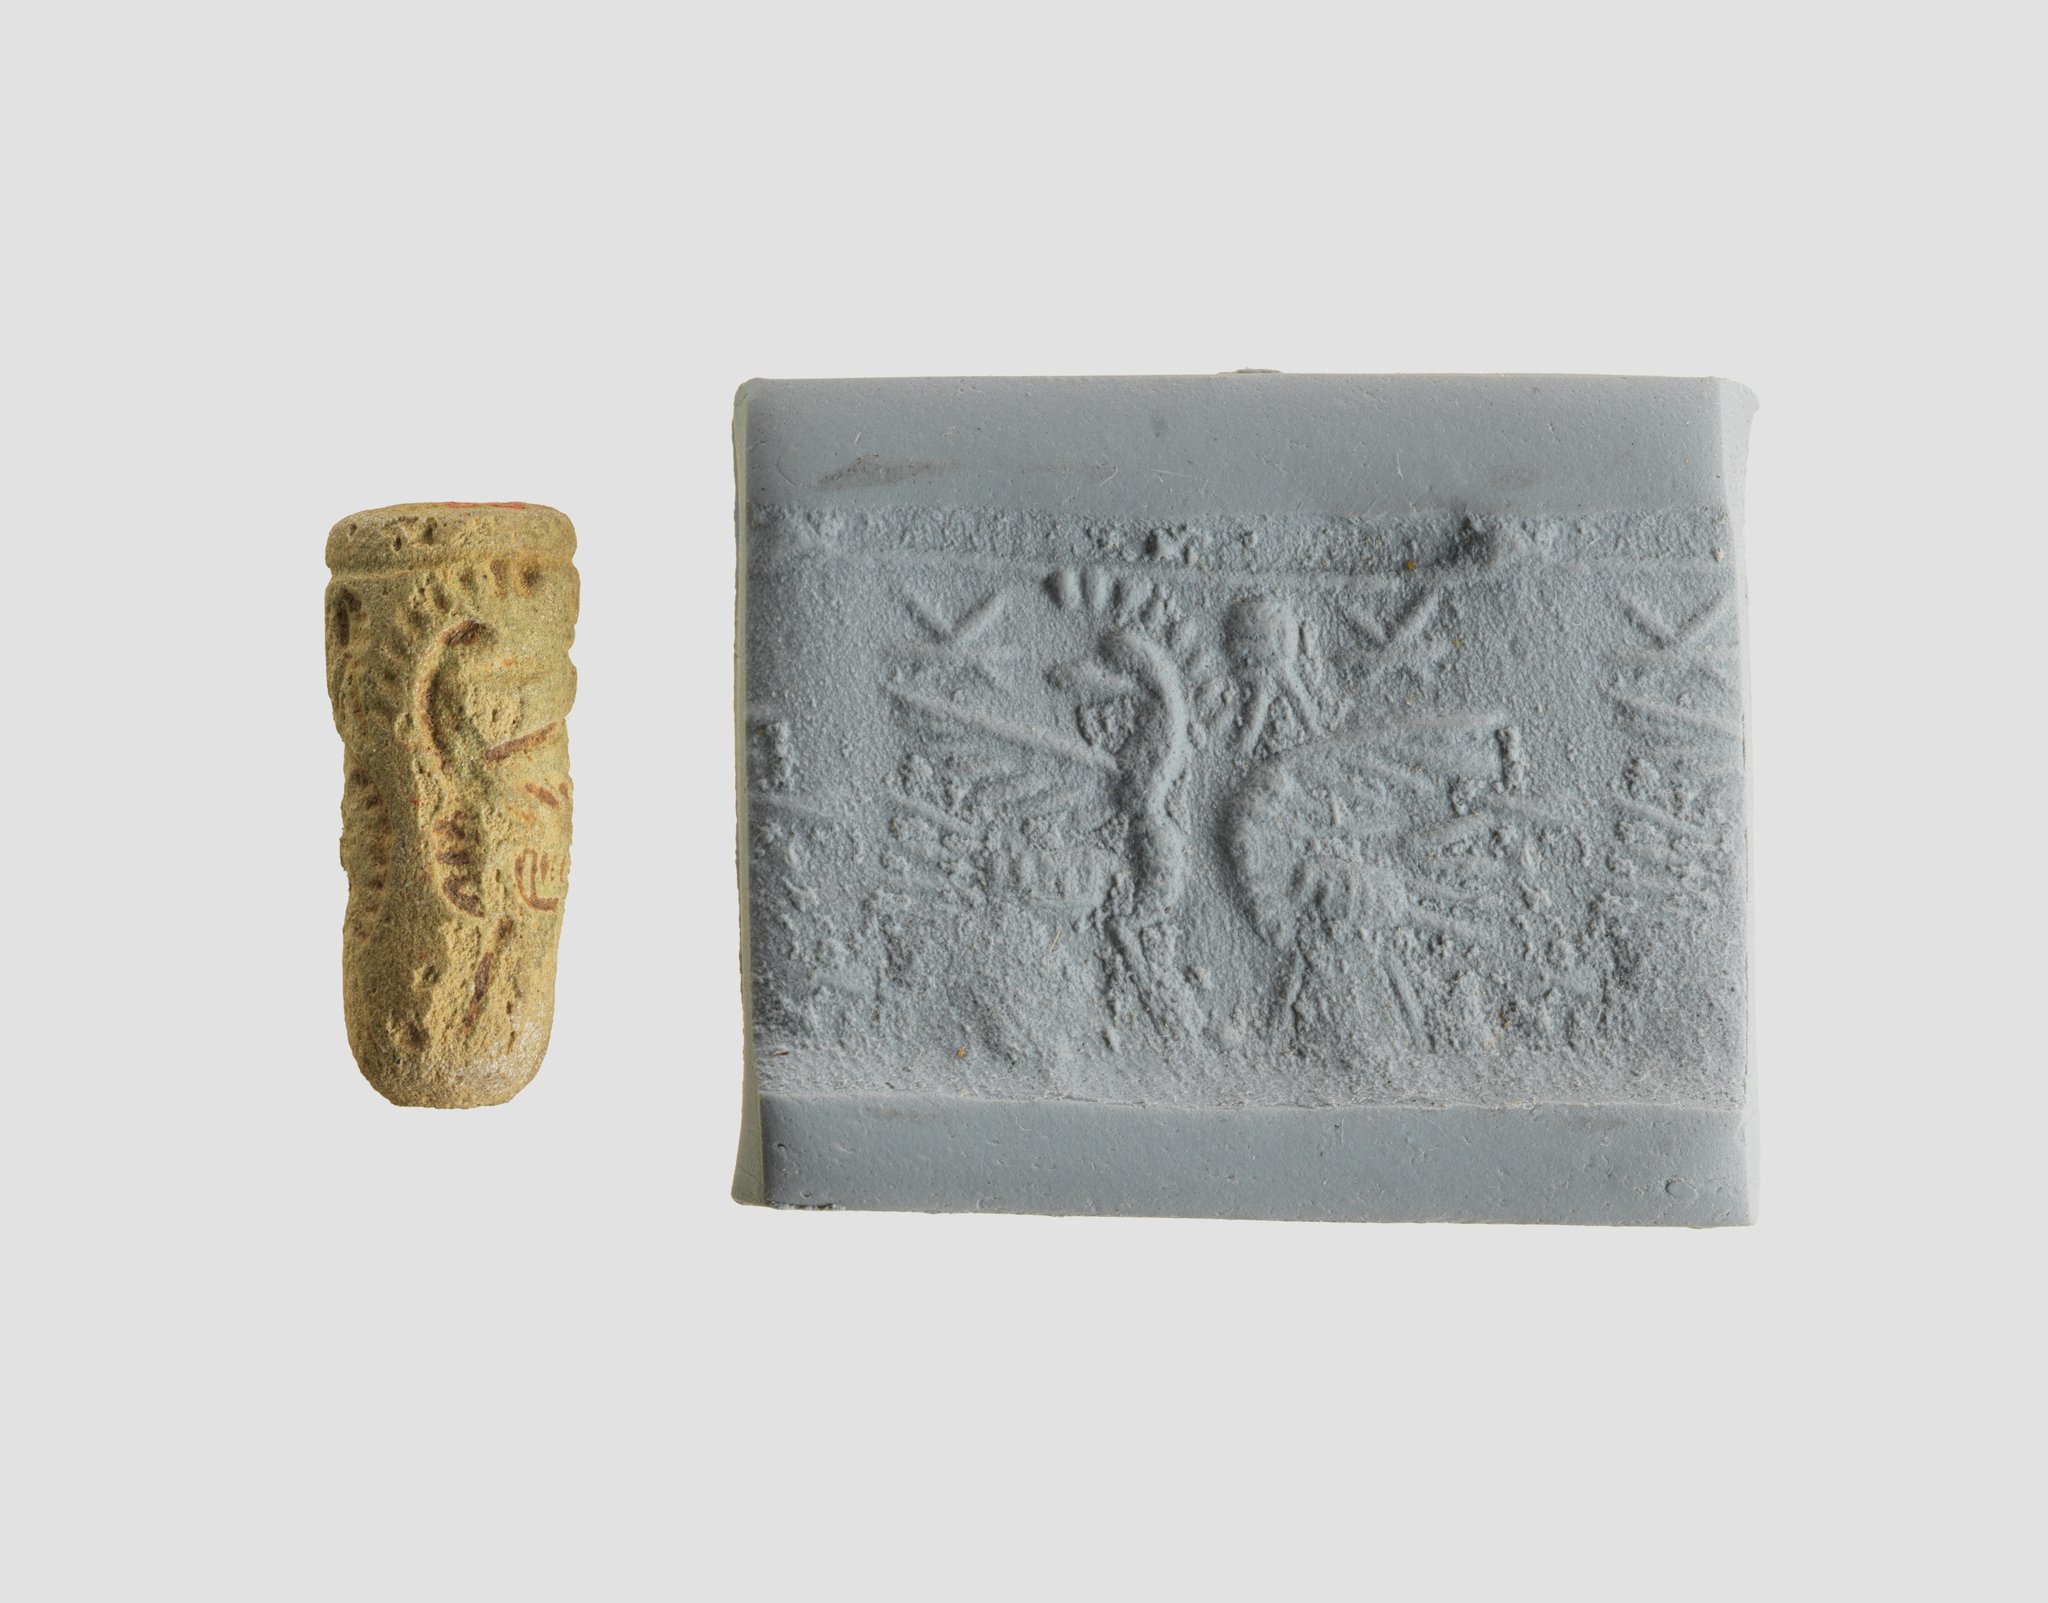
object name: cylinder seal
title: Cylinder seal with monsters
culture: assyrian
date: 800-601 BCE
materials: faience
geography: iran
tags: birds